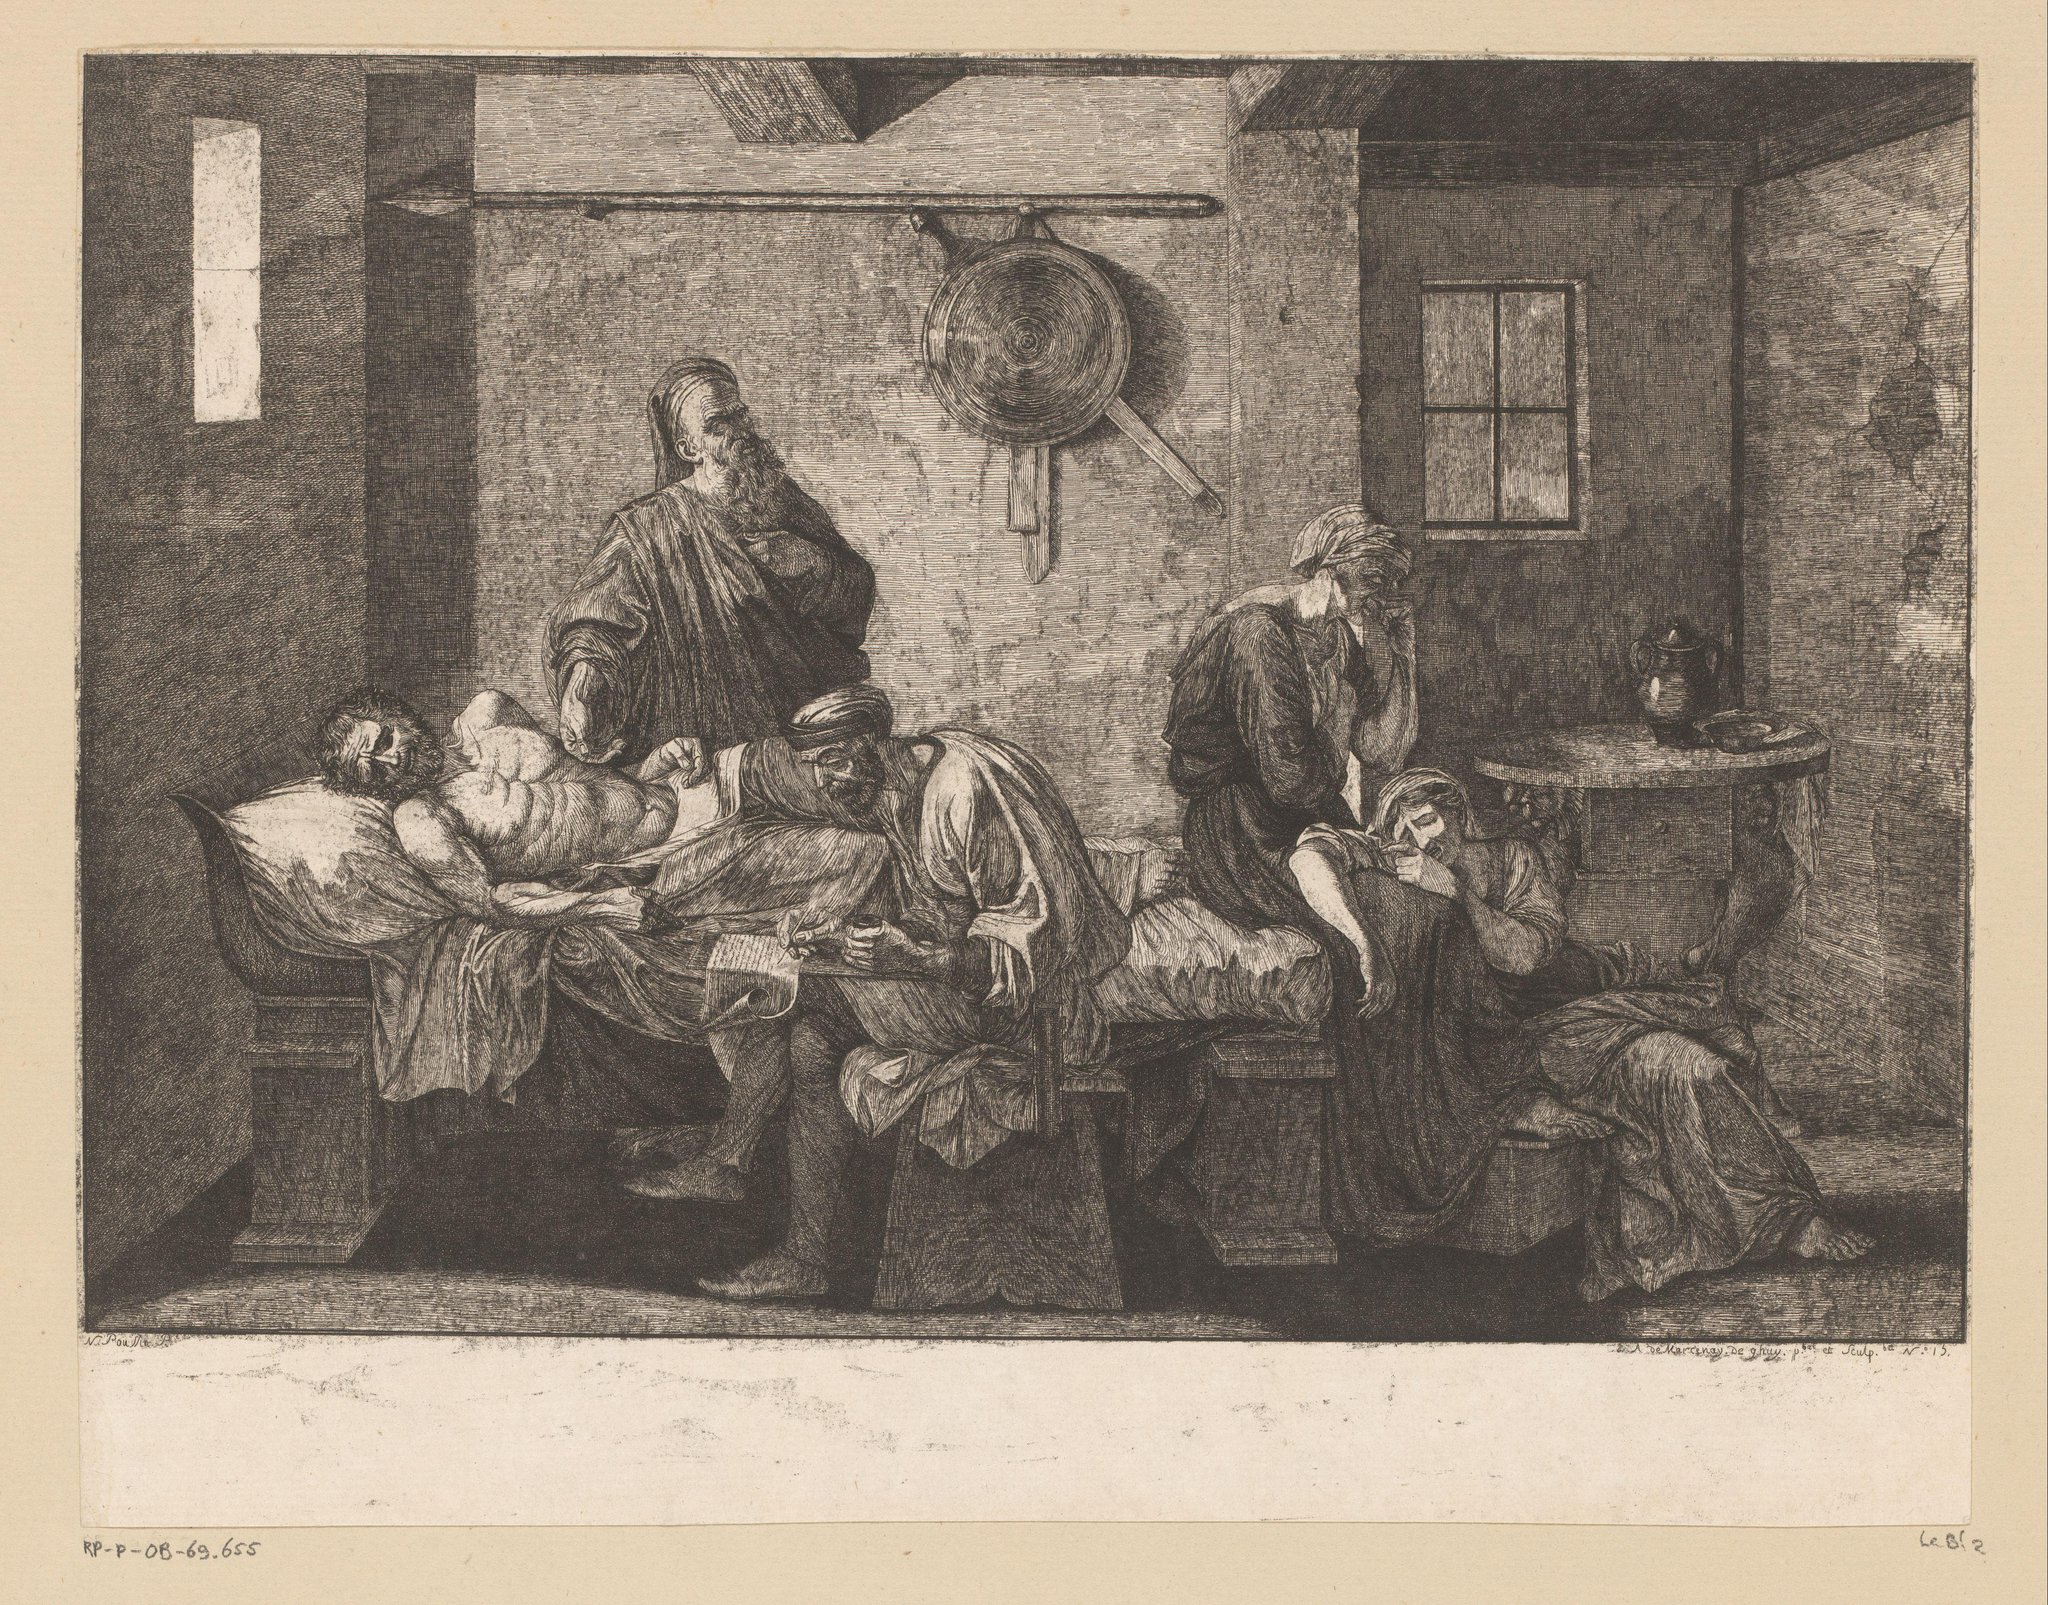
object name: print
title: Testament van Eudamidas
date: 1734-1811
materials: paper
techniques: etching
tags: making a testament, death of eudamidas: on his deathbed, having no money, he entrusts his mother and daughter to the good care of his two friends; the testament of eudamidas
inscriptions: collector's mark: Lugt 2228